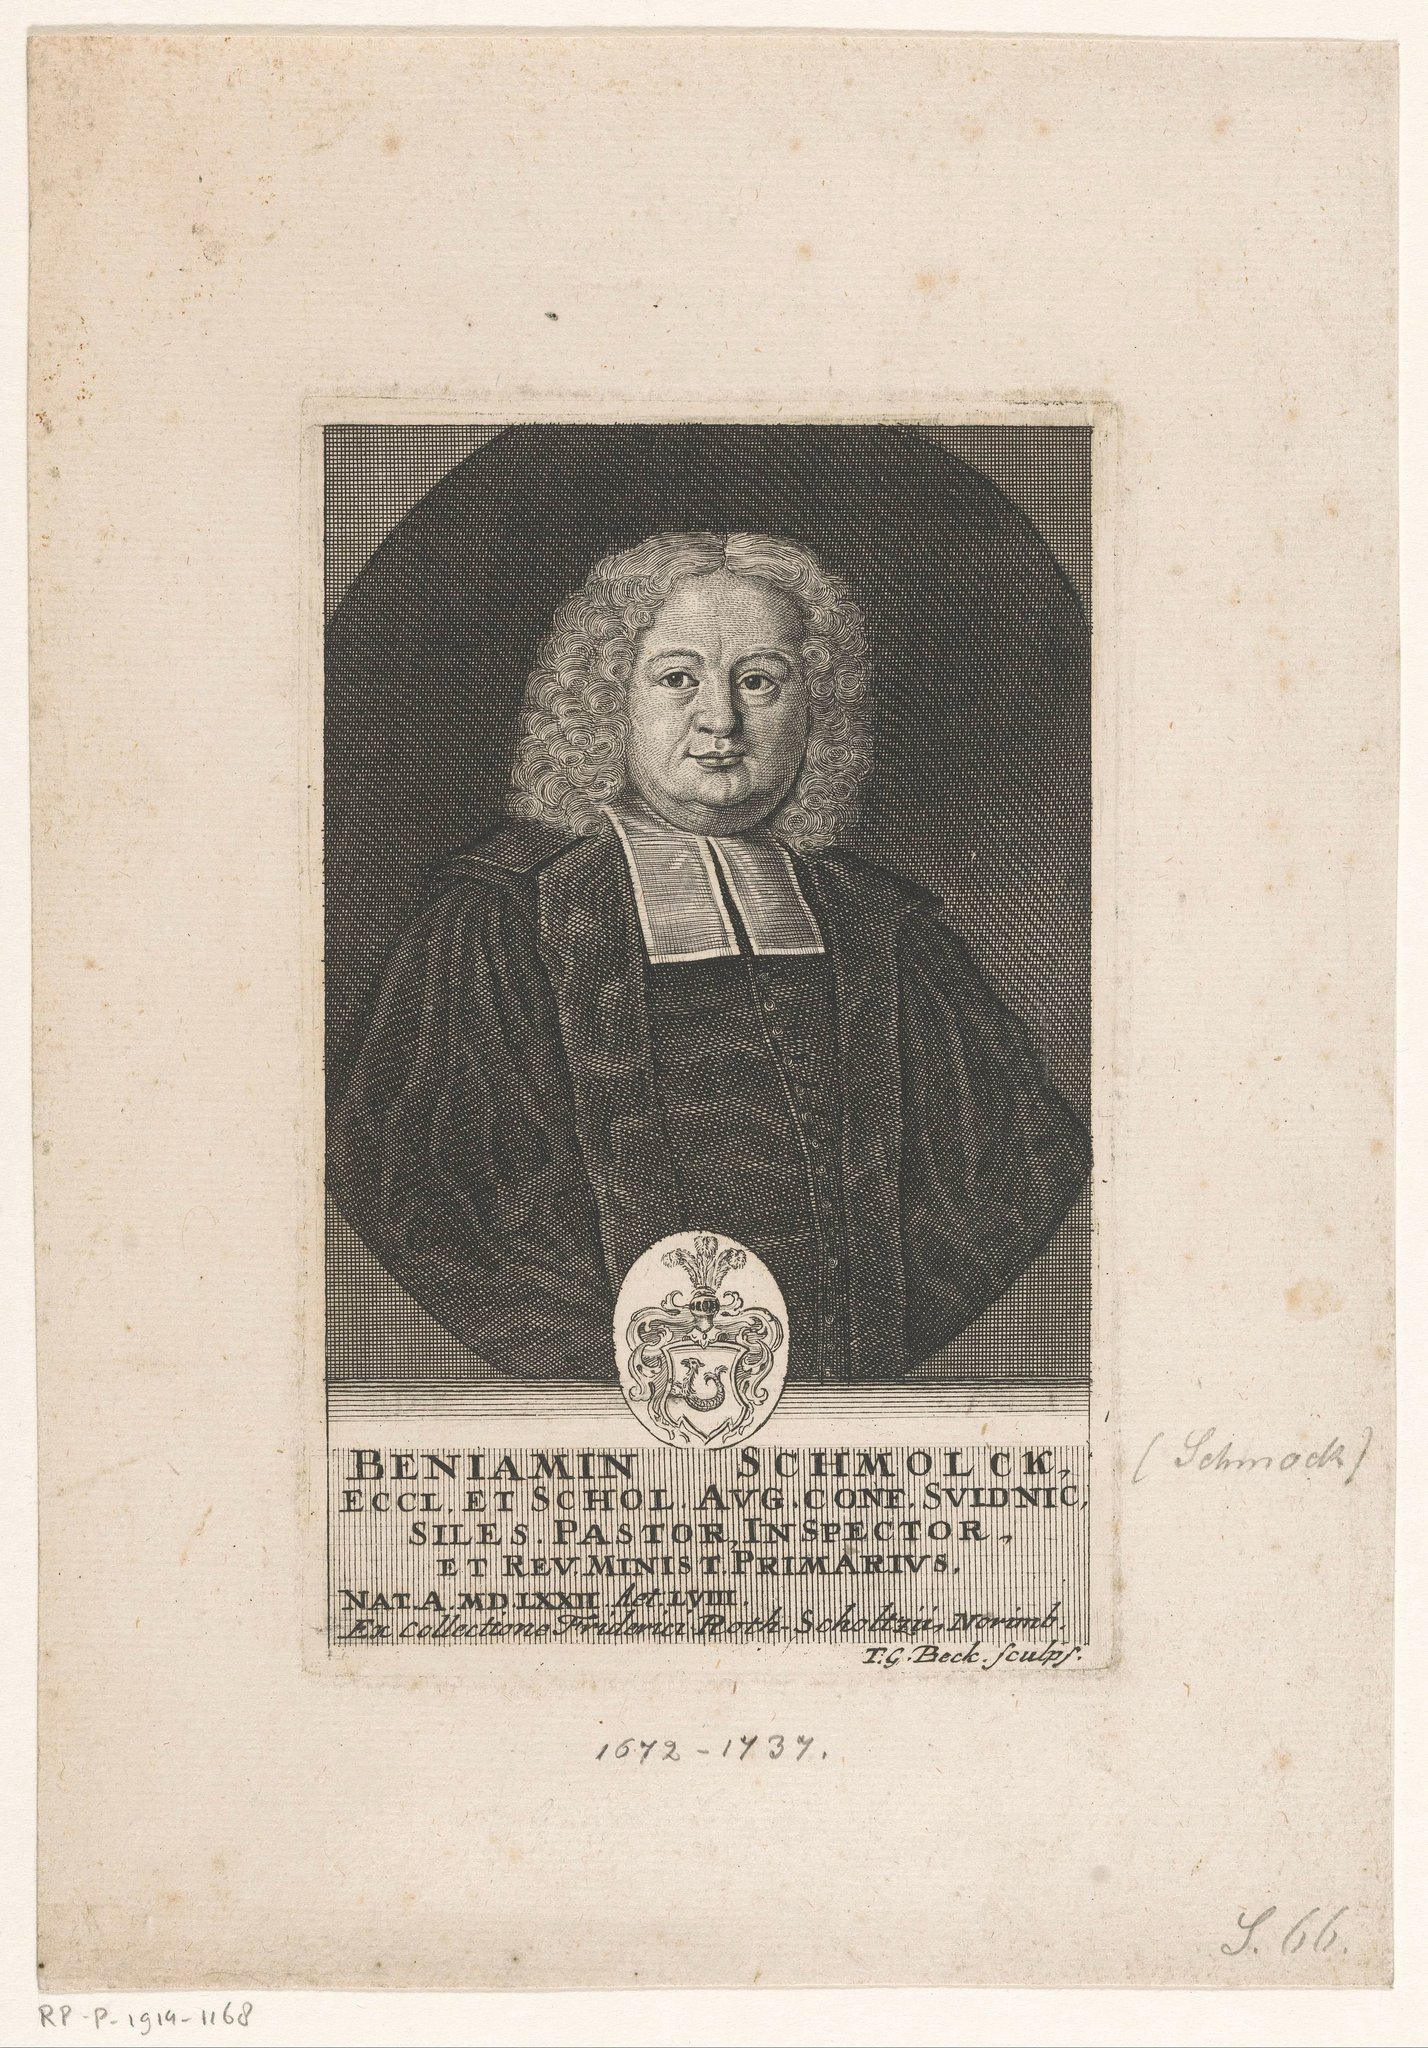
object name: print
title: Portret van Benjamin Schmolck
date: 1730-1755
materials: paper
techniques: engraving, etching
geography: nuremberg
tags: historical persons, armorial bearing, heraldry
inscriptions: collector's mark: Lugt 2228